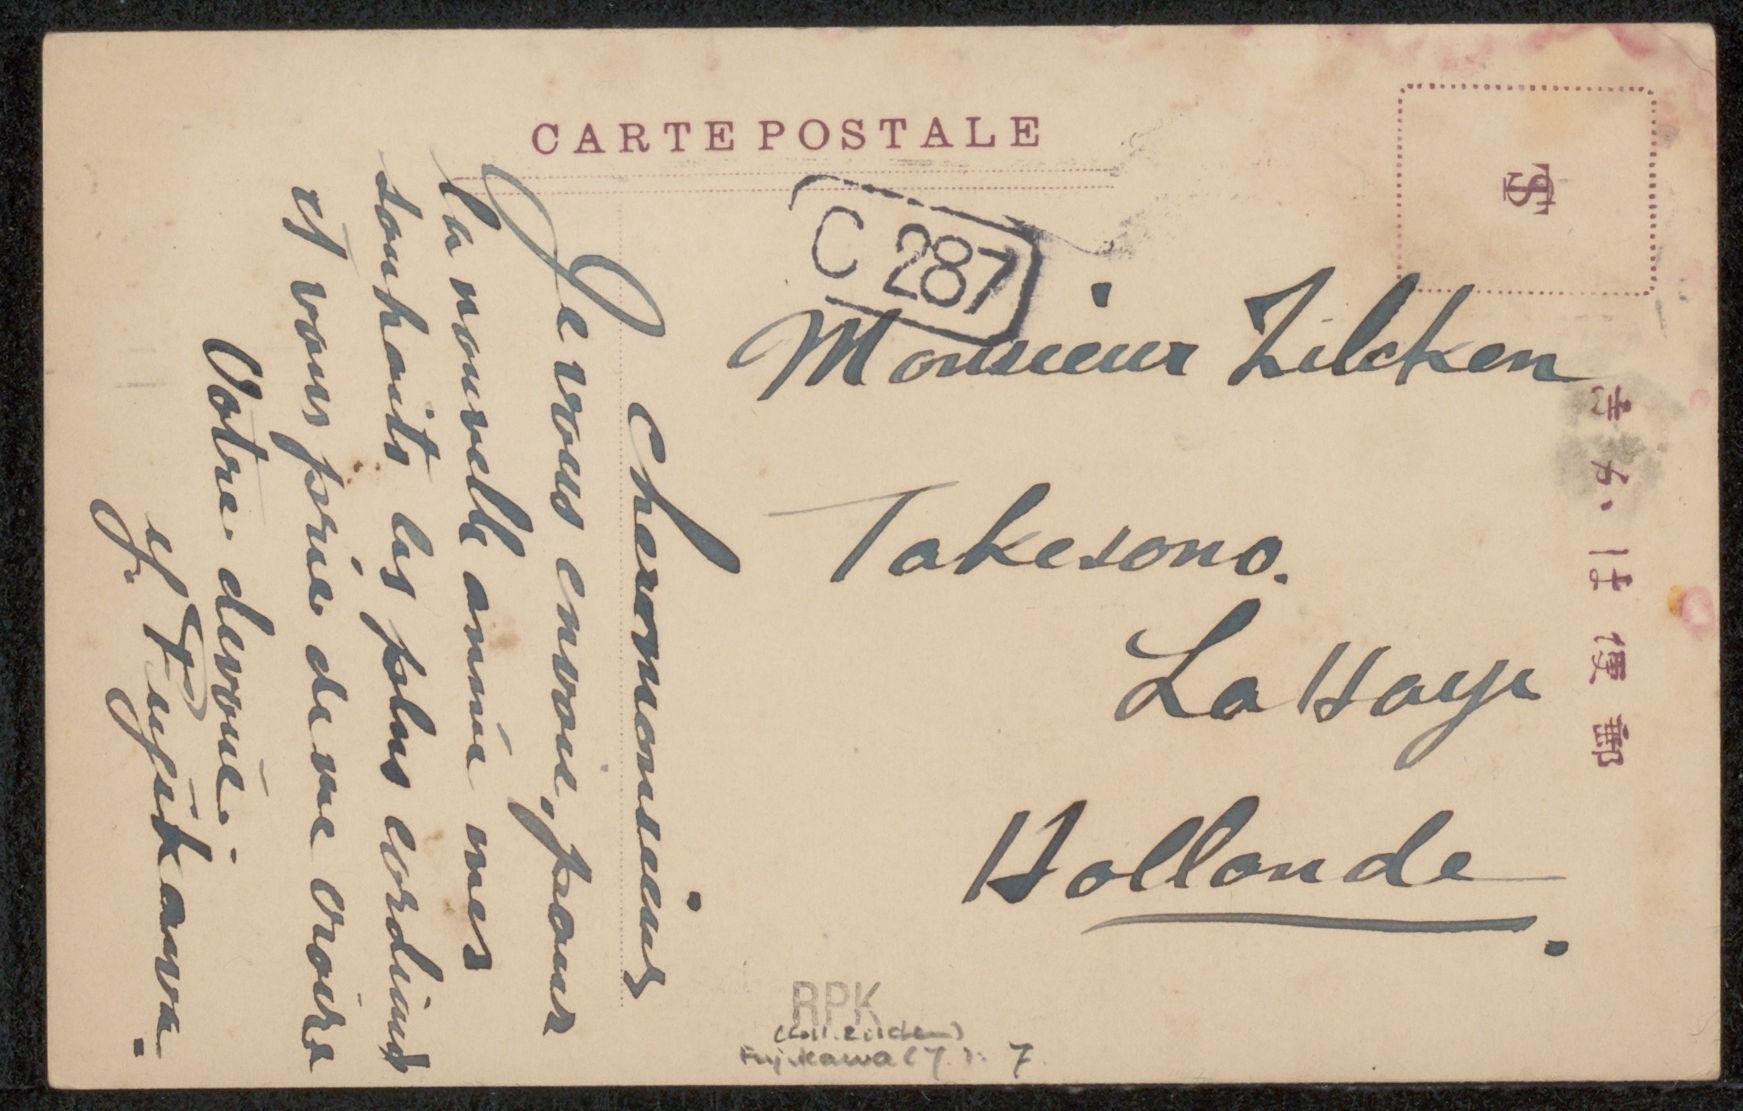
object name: ansichtkaart, prentbriefkaart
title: Prentbriefkaart aan Philip Zilcken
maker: j. fujikawa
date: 1867-1930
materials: cardboard, ink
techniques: woodcut, pen, writing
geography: paris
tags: painter, draughtsman, philip zilcken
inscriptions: collector's mark: ‘RPK’